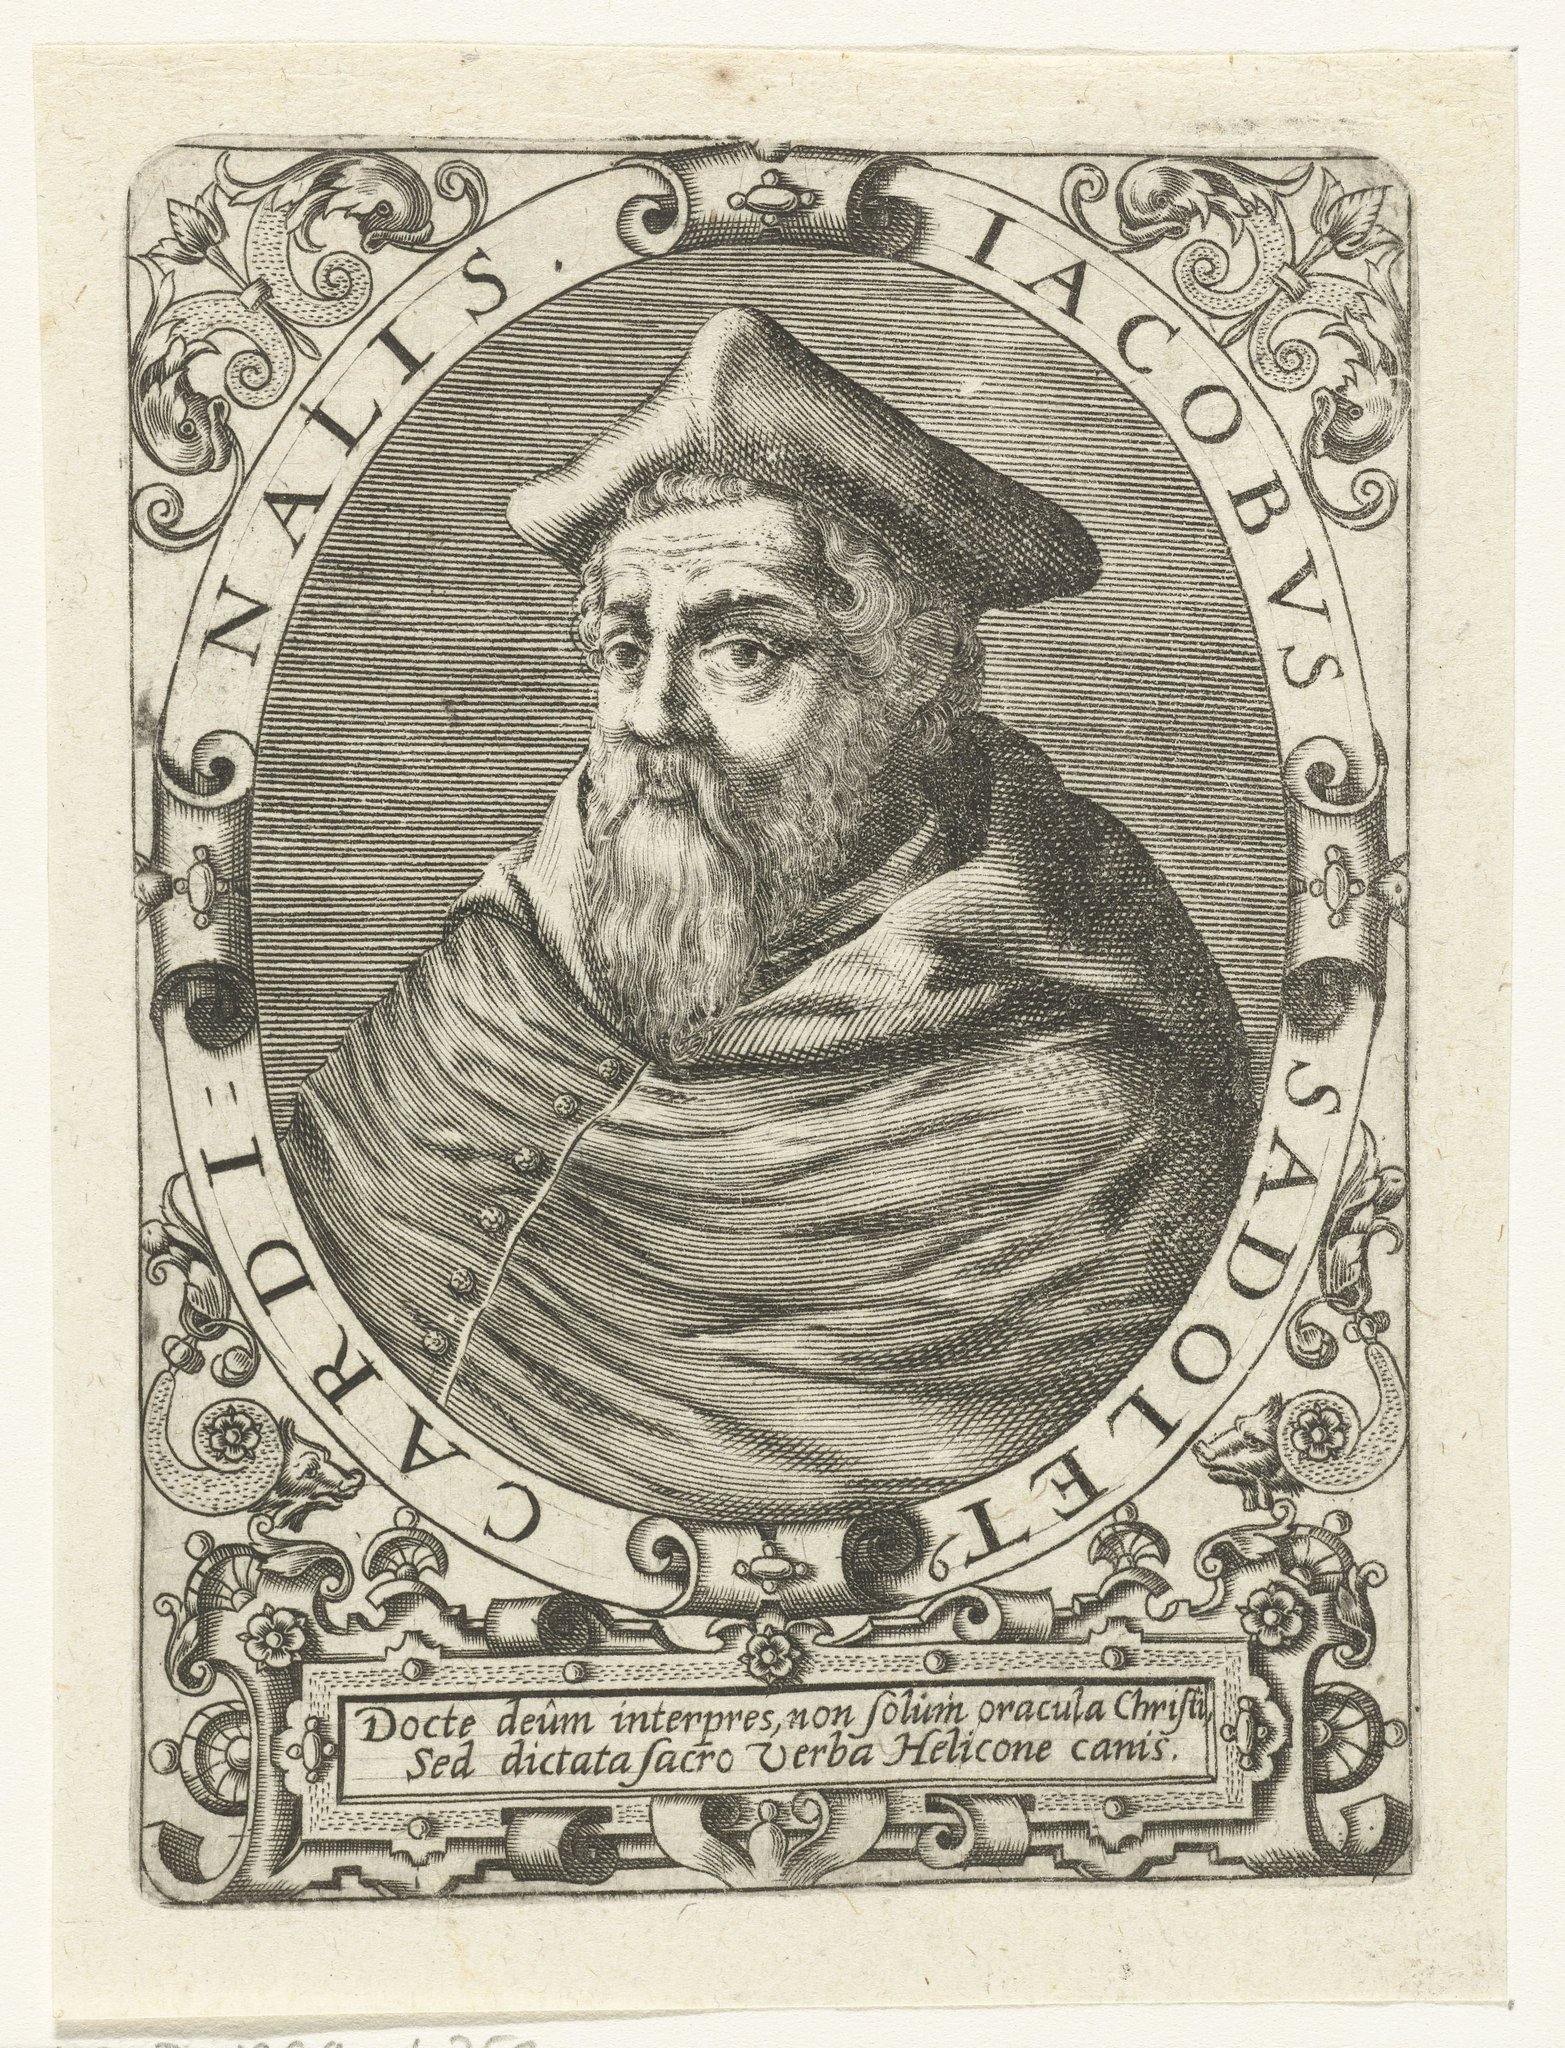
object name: print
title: Portret van Jacopo Sadoleto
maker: jean jacques boissard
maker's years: 1528-1598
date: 1597-1599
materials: paper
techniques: engraving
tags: rome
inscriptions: collector's mark: Lugt 2228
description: Gemaakt voor: J.J. Boissard, Icones virorum illustrium doctrina &c eruditione praestanti um contines. Frankfurt am Main: de Bry, 1597-1599.